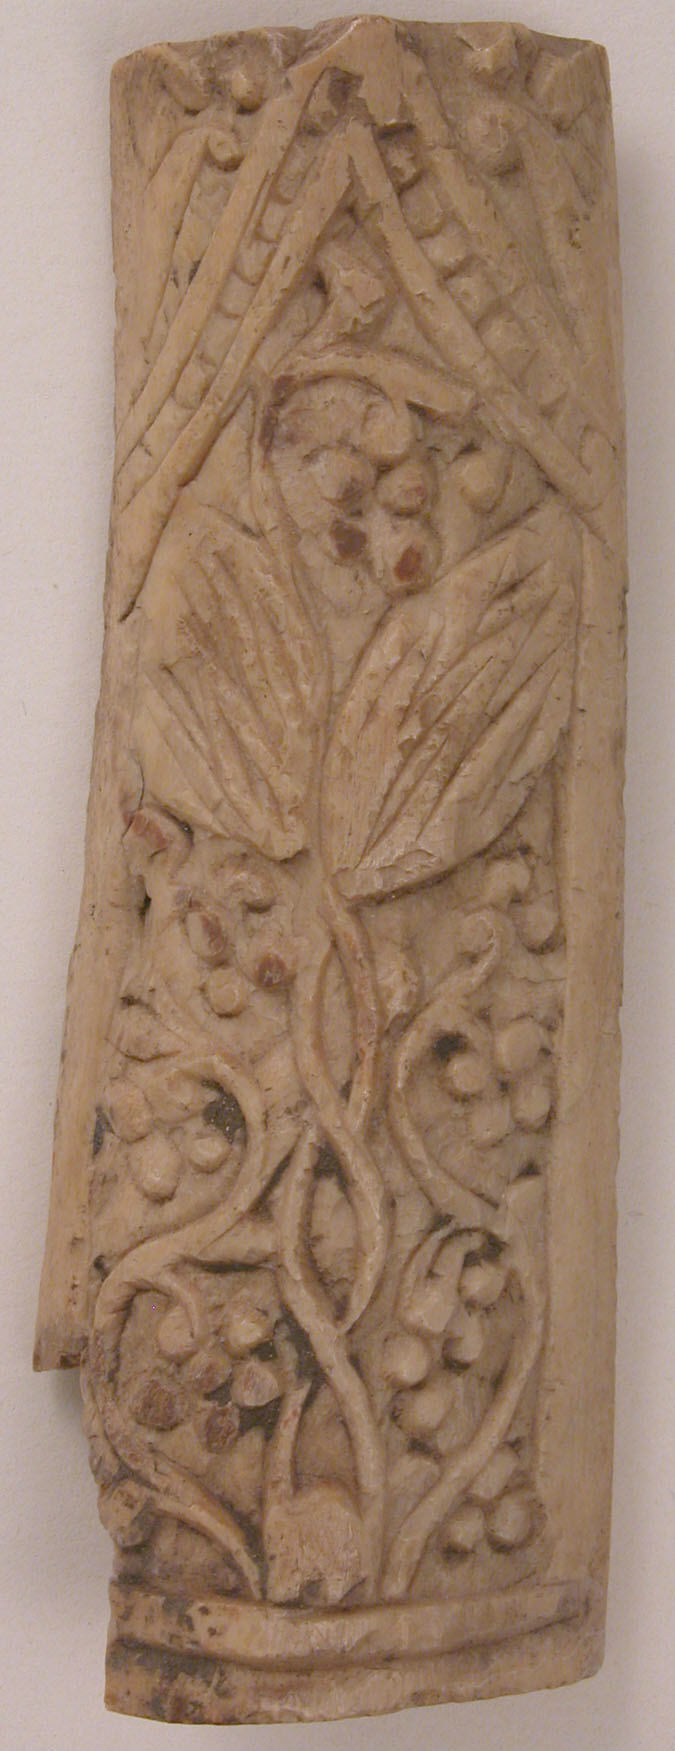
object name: plaque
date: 501-700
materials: bone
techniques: carving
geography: egypt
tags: flowers,leaves